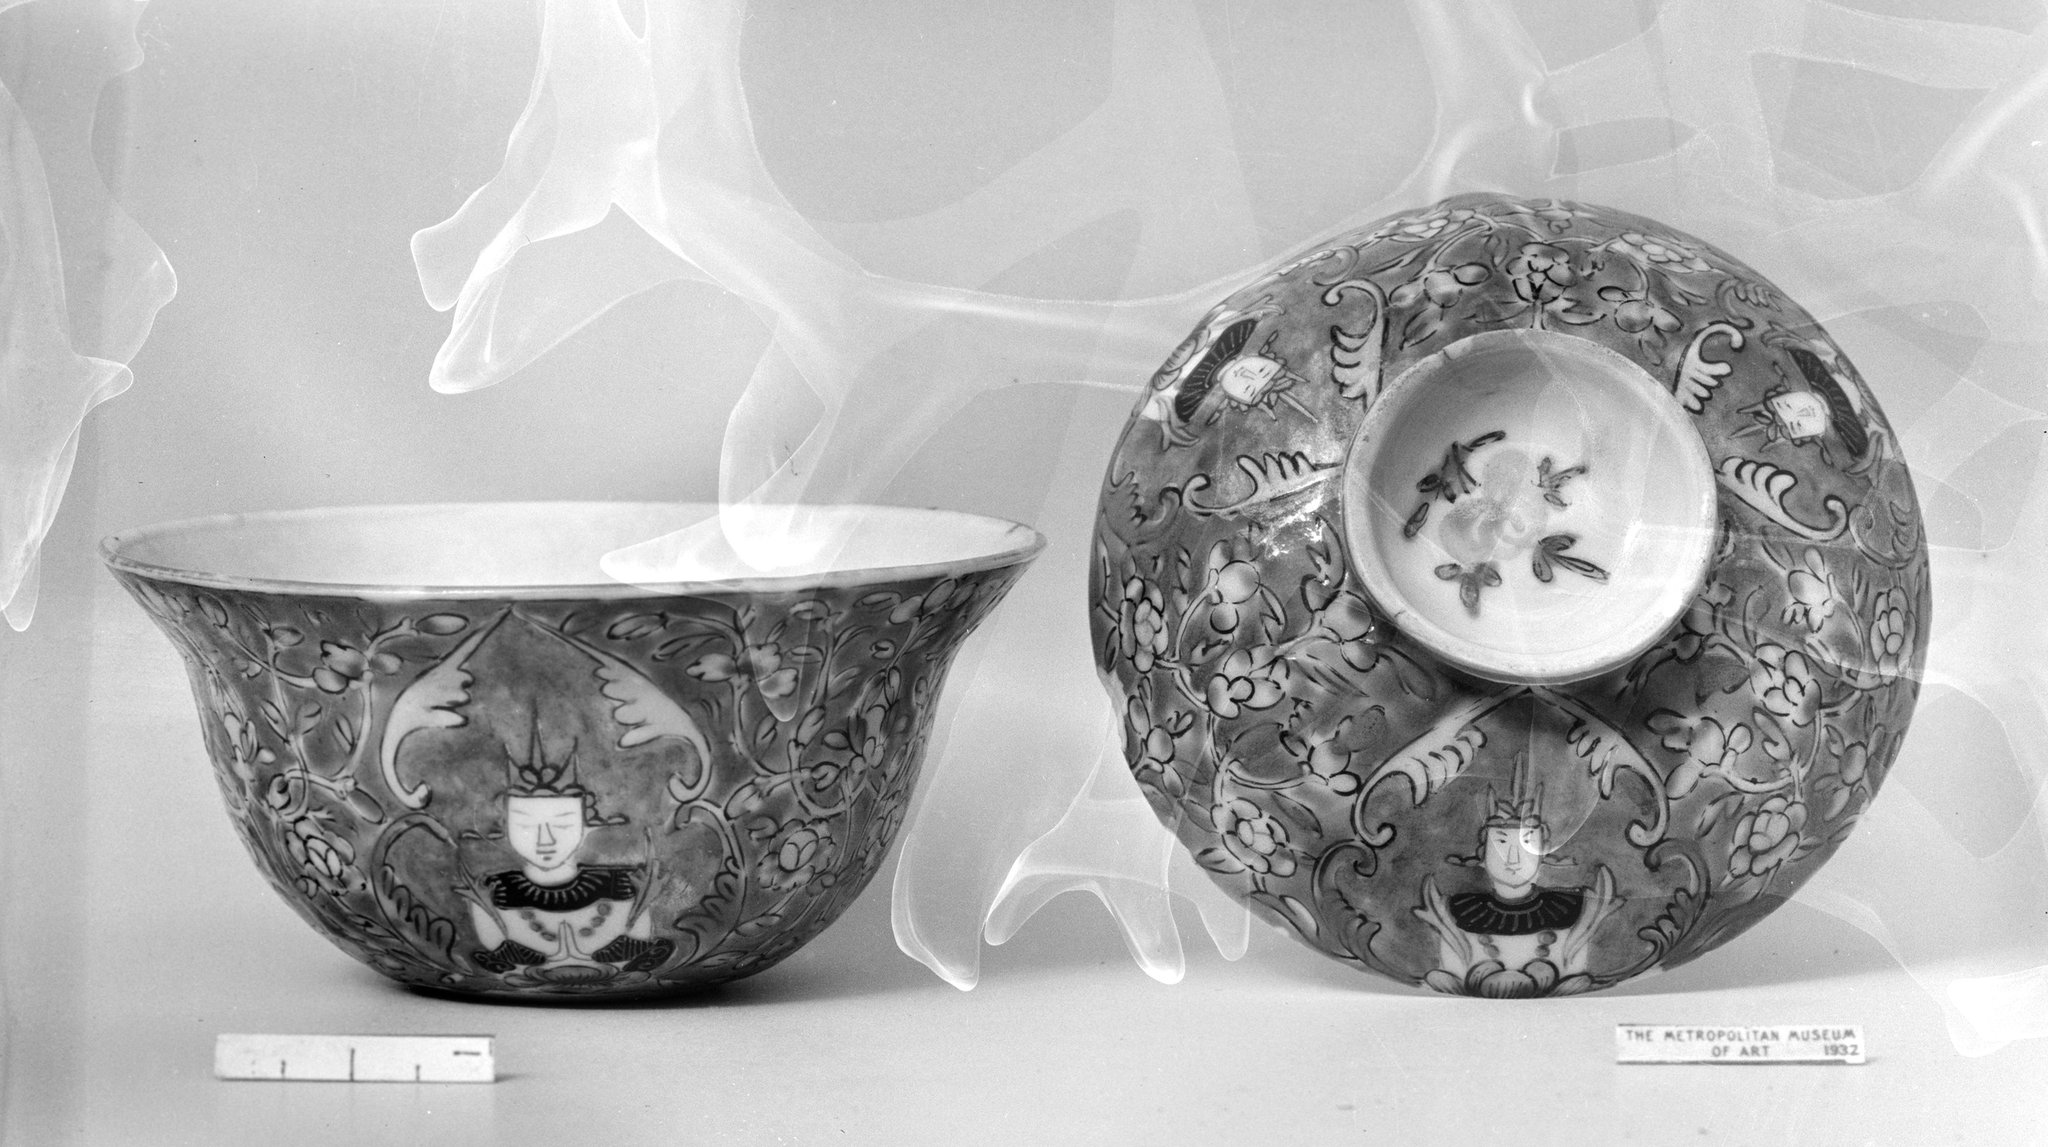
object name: covered bowl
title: Covered bowl with Thai mythical figures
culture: chinese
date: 1801-1900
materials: enamel, porcelain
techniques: overglaze, painting, polychrome